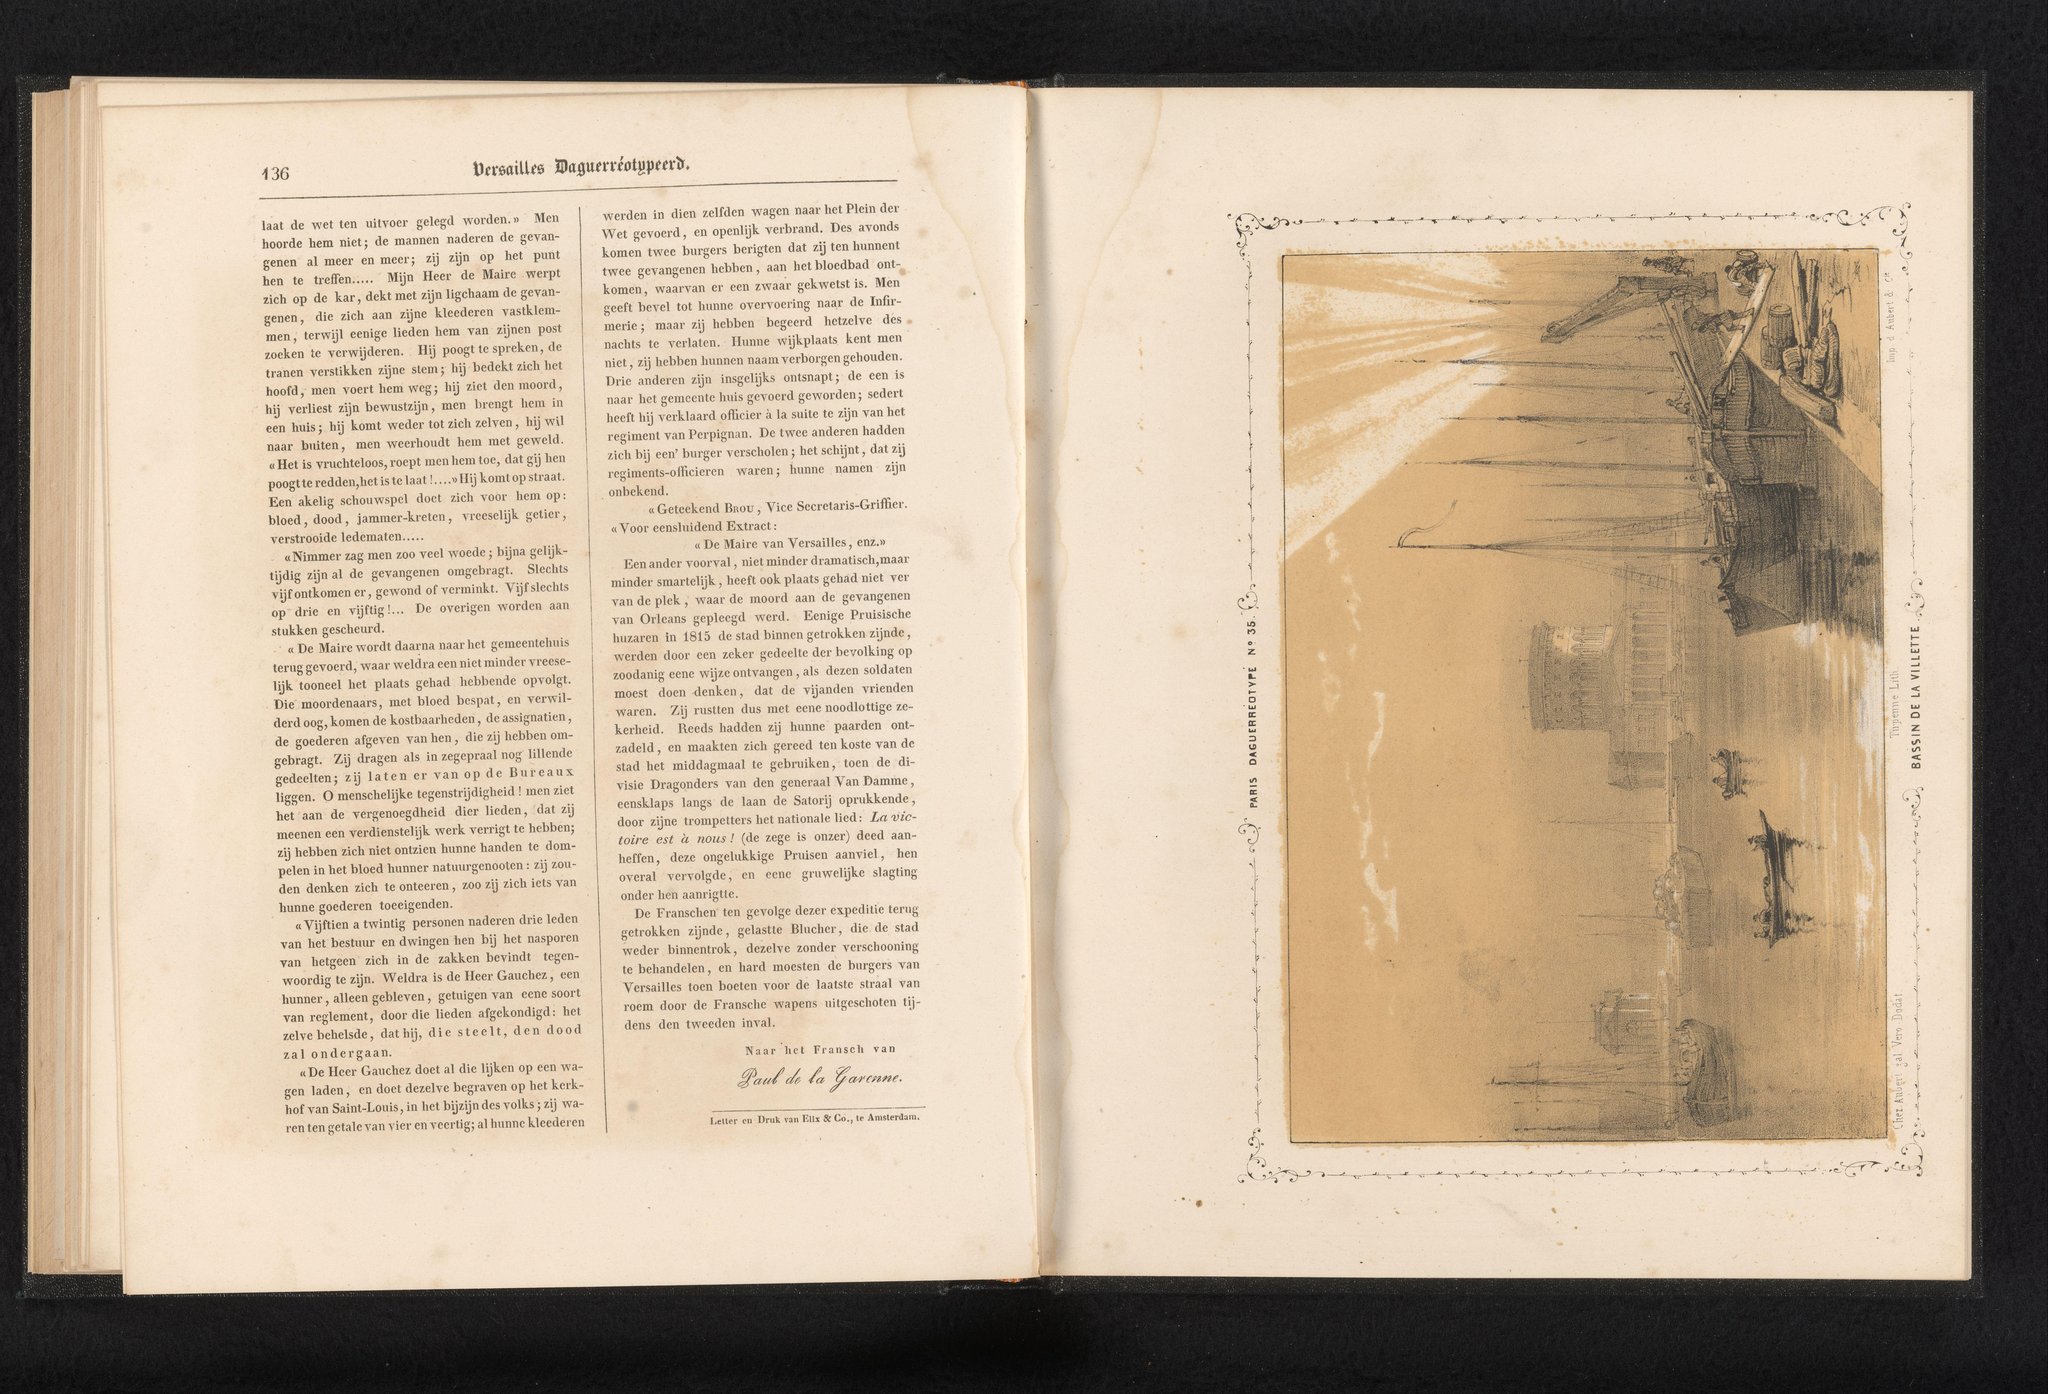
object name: page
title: Bassin de la Villette in Parijs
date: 1839-1840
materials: paper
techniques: tone lithography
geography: paris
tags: canals, waters (in city)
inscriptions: inscription: ‘PARIS DAGUERRÉOTYPÉ No. 35.’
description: Prent op honderdnegenendertigste ongenummerde pagina.